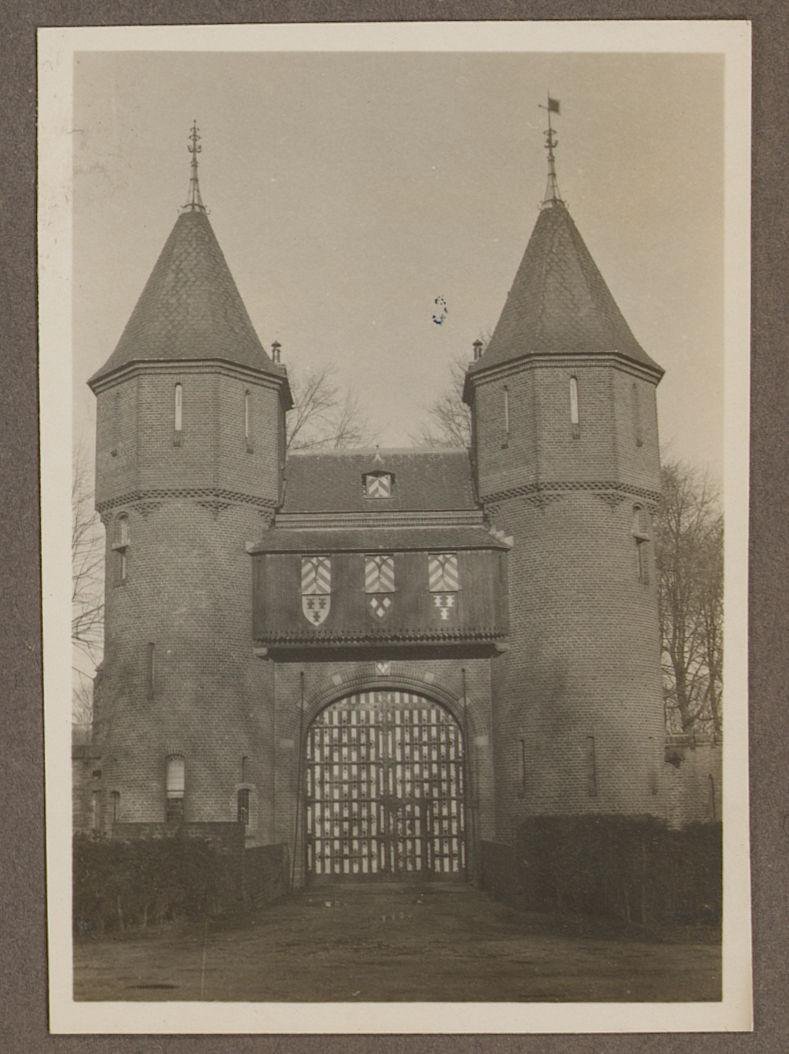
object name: photograph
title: Poort van kasteel de Haar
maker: Anonymous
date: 1930-1935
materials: paper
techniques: gelatin silver print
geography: haarzuilens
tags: castle, gate, entrance